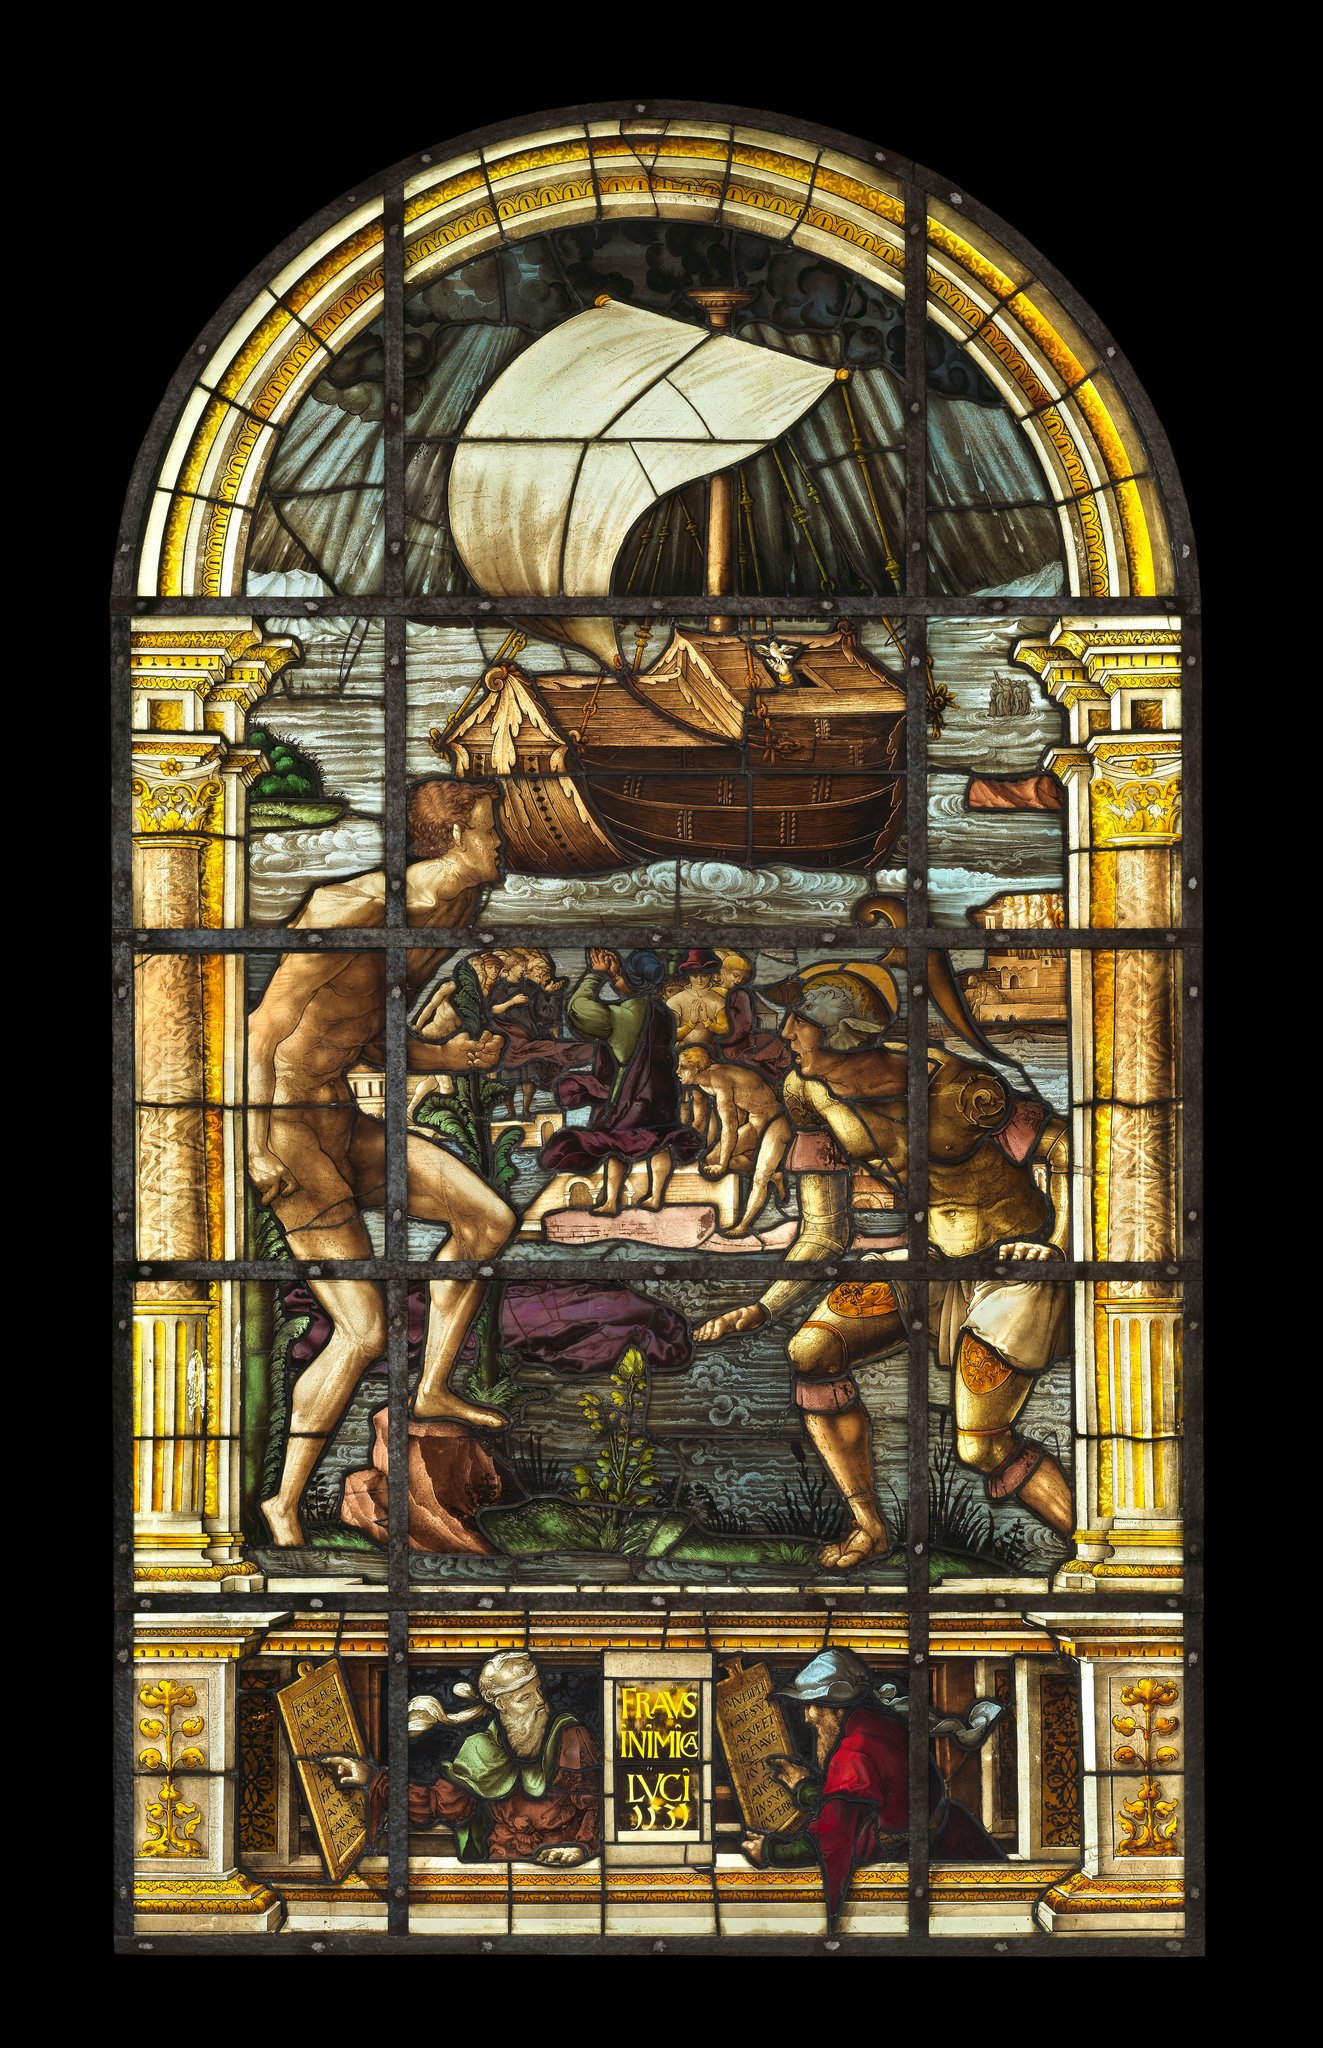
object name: window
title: The Deluge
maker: valentin bousch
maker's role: artist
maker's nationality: french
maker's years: 1514-1541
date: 1531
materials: glass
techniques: painting, stain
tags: soldiers,men,floods,boats